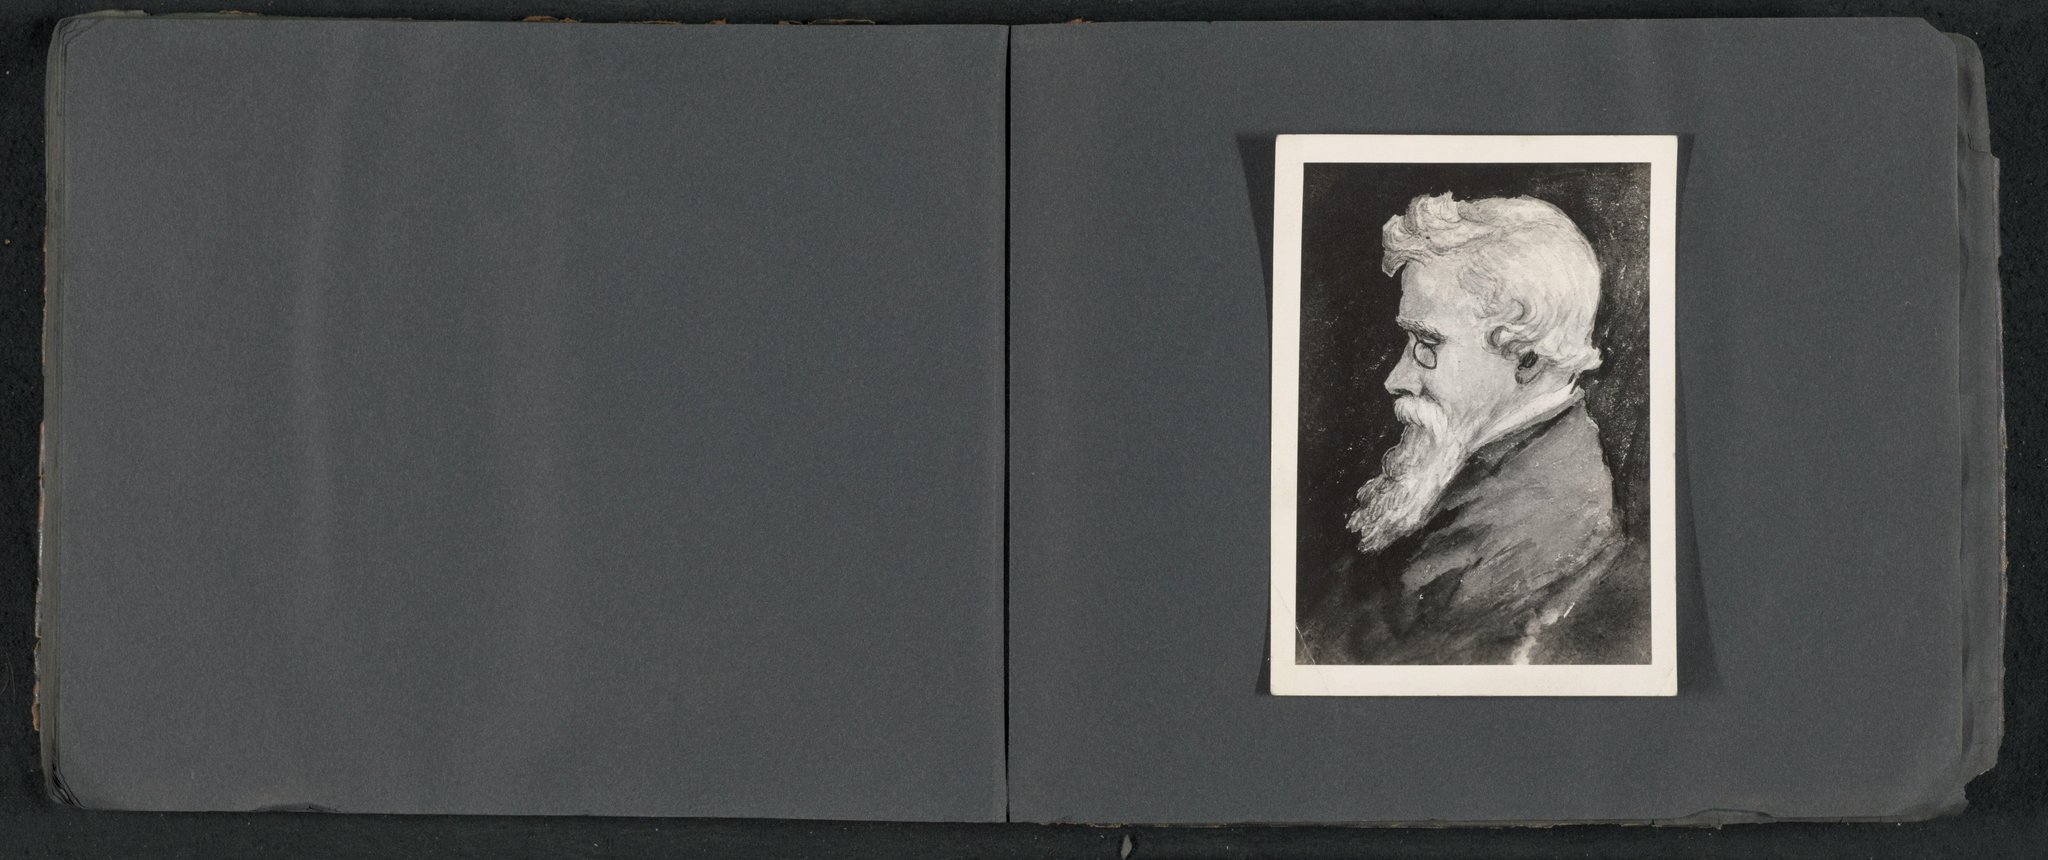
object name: photograph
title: Fotoreproductie van (vermoedelijk) een tekening van een man met een baard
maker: Anonymous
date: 1890-1902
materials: photographic support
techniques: gelatin silver print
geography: united states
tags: adult man, historical persons, beard, united states of america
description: Onderdeel van Familiealbum met voornamelijk foto's van een jong Amerikaans meisje.